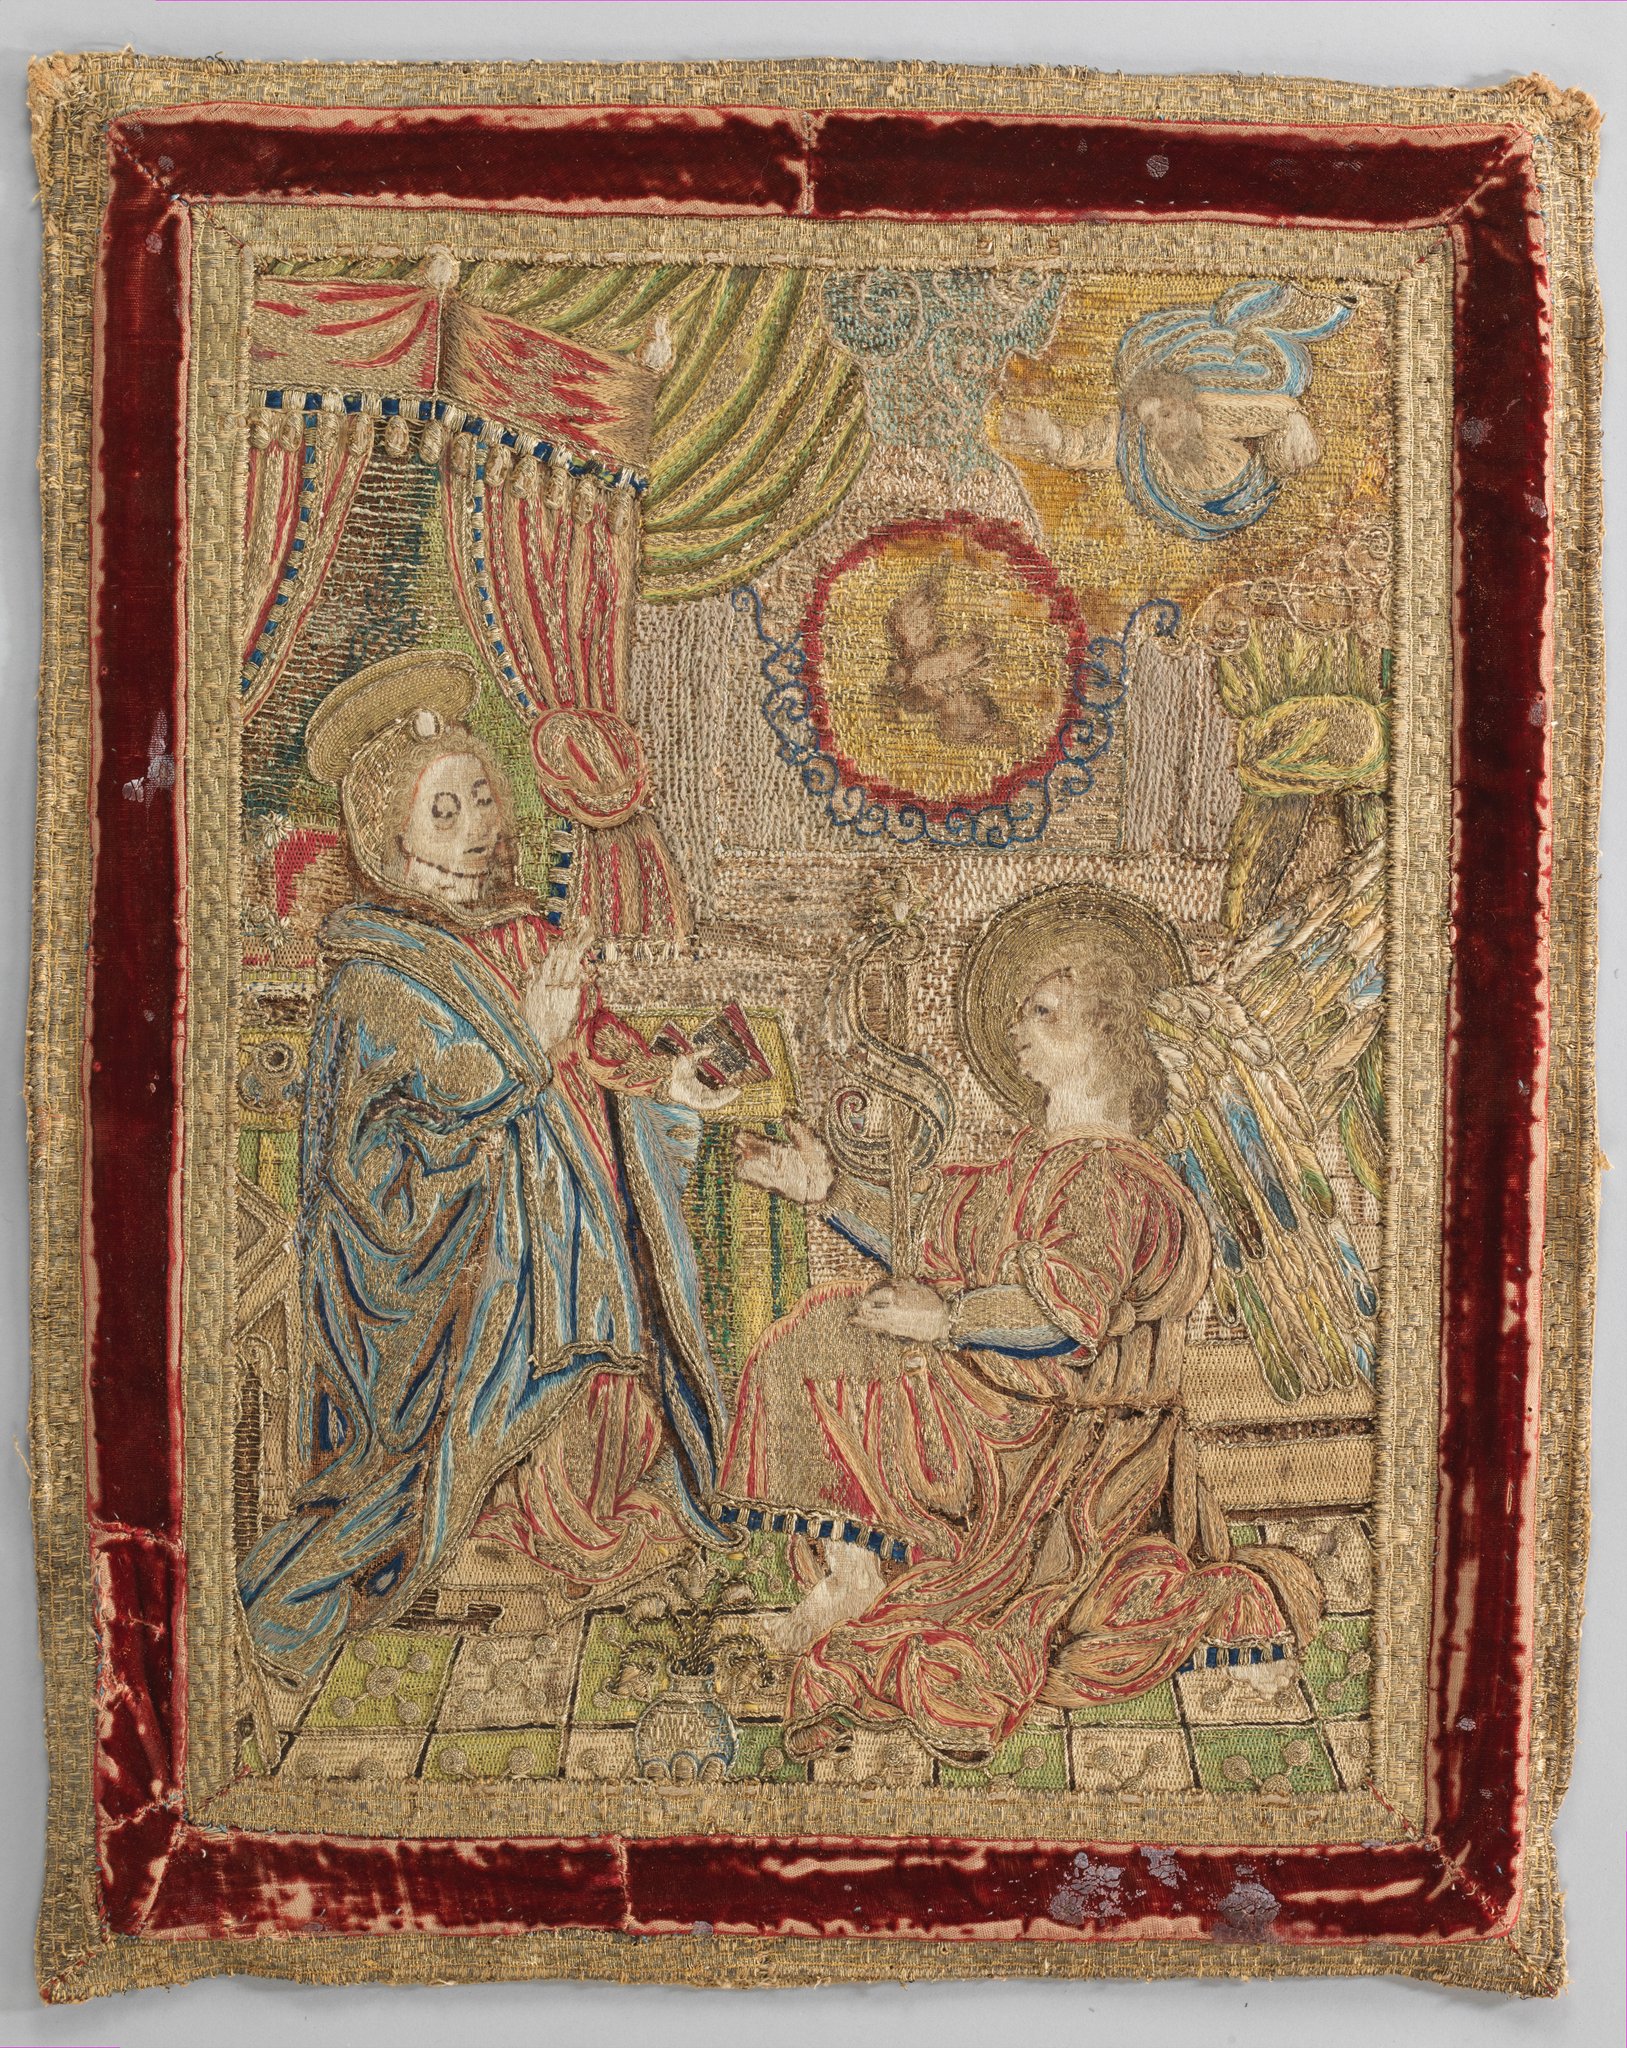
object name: embroidery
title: The Annunciation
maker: federico barocci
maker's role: designer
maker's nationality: italian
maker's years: 1535-1612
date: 1600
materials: metal thread, silk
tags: virgin mary,archangel gabriel,annunciation